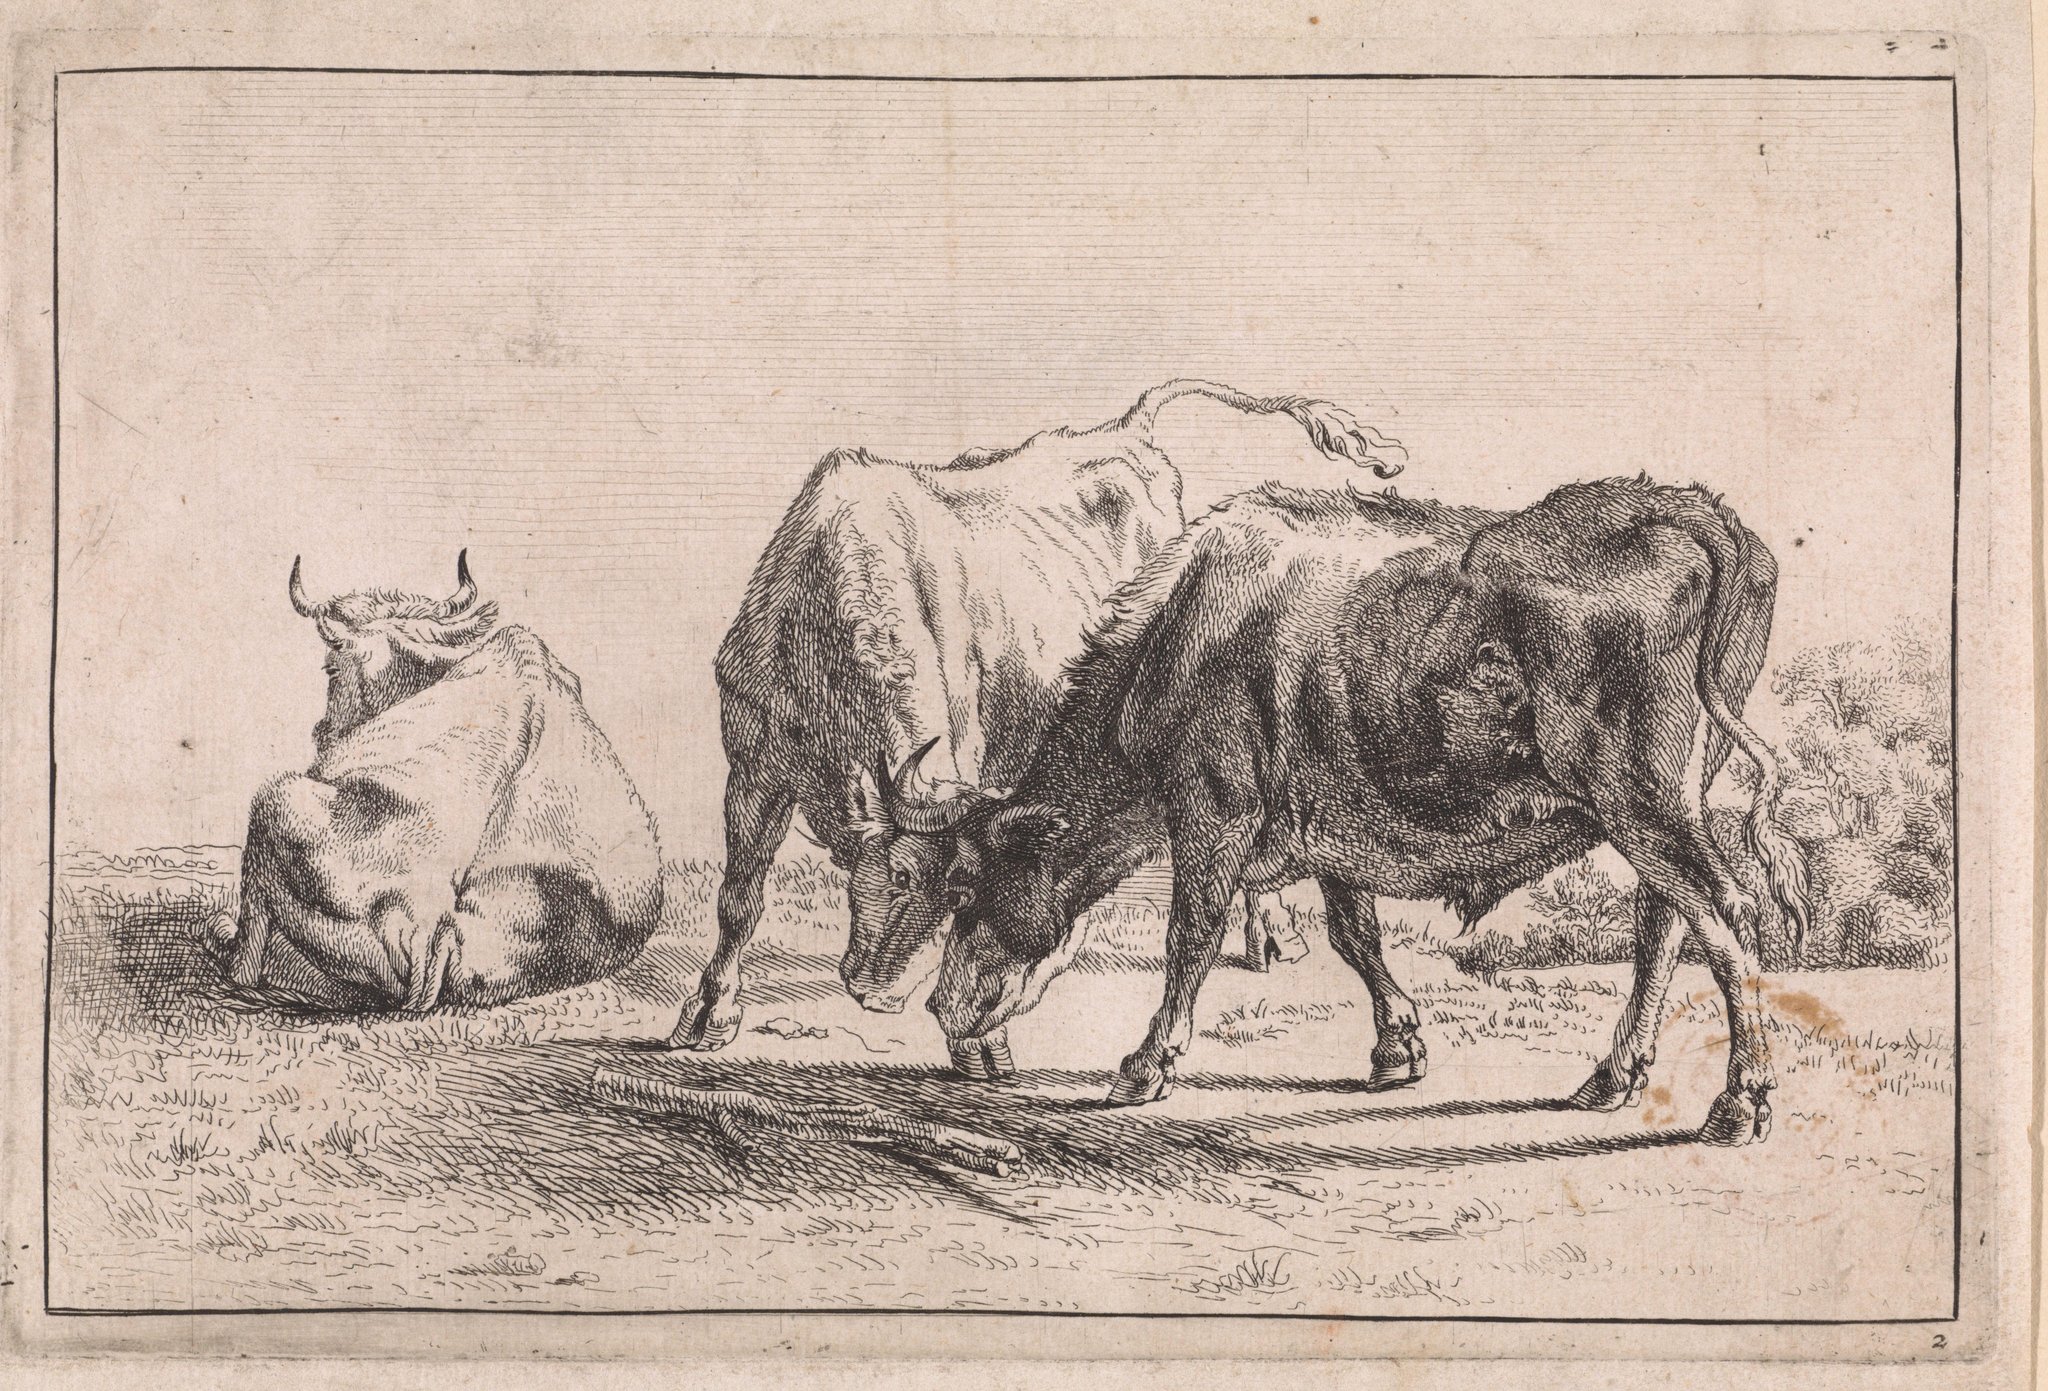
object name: print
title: Twee vechtende ossen en liggende koe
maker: Anonymous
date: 1635-1704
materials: paper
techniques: etching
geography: netherlands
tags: cow, ox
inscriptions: collector's mark: Lugt 240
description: Deze kopie is opgebouwd uit verschillende elementen in spiegelbeeld van prenten uit de serie Het Bullenboekje van Paulus Potter. Respectievelijk, de Twee vechtende ossen en de liggende koe uit Een staande en een liggende koe.